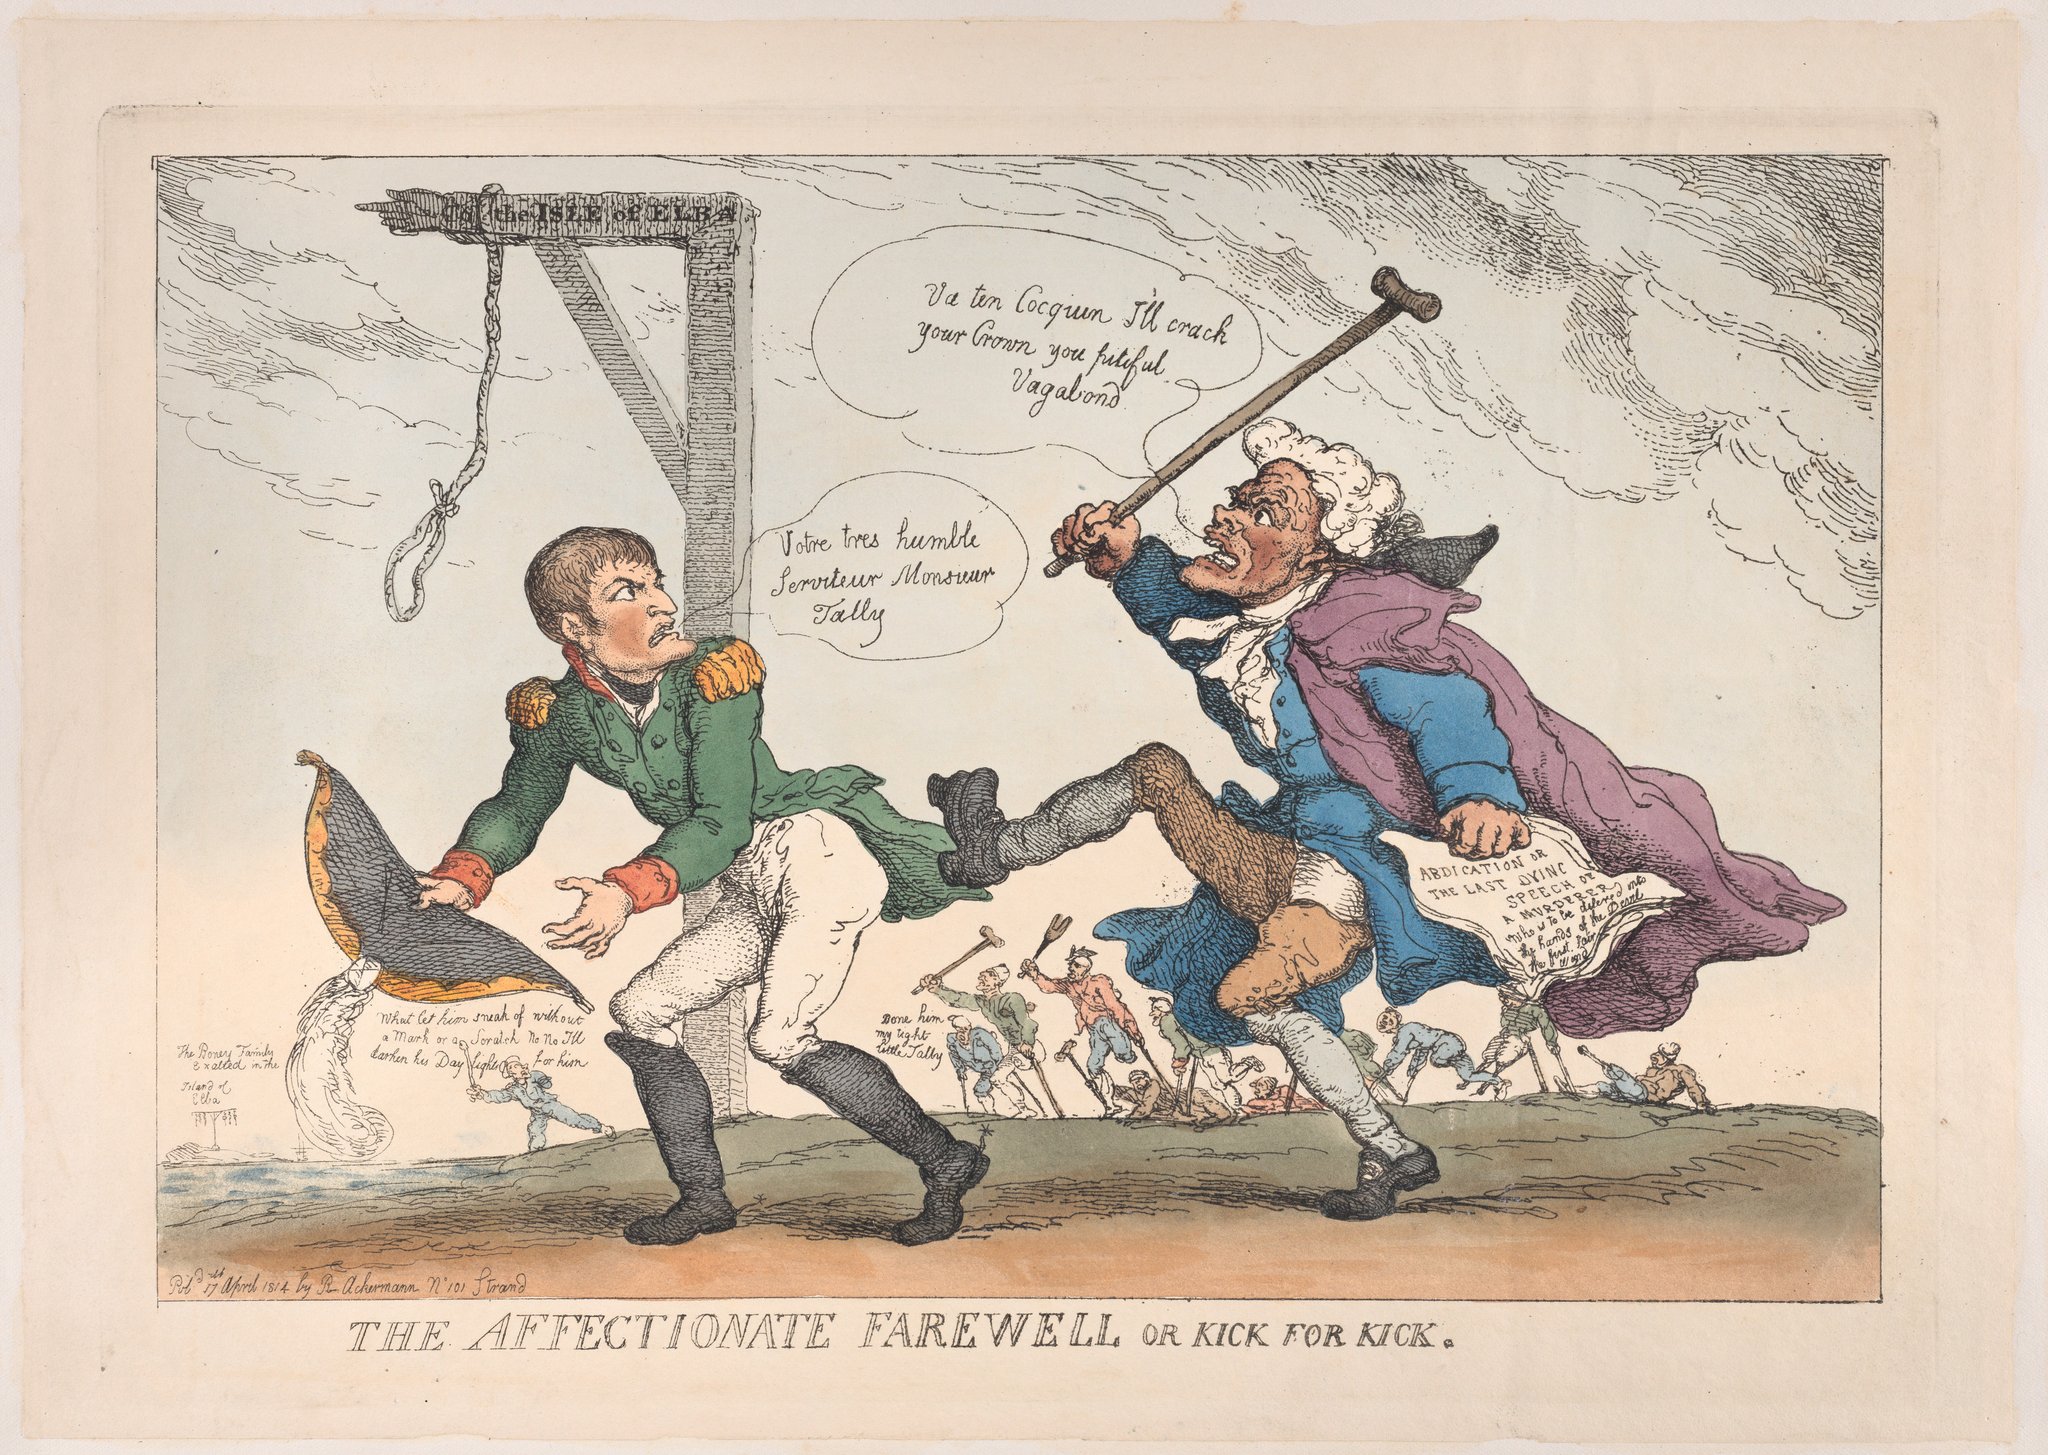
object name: print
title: The Affectionate Farewell, or Kick for Kick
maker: thomas rowlandson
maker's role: artist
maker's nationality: british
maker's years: 1757-1827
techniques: etching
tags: satire,napoleon i,men,politics